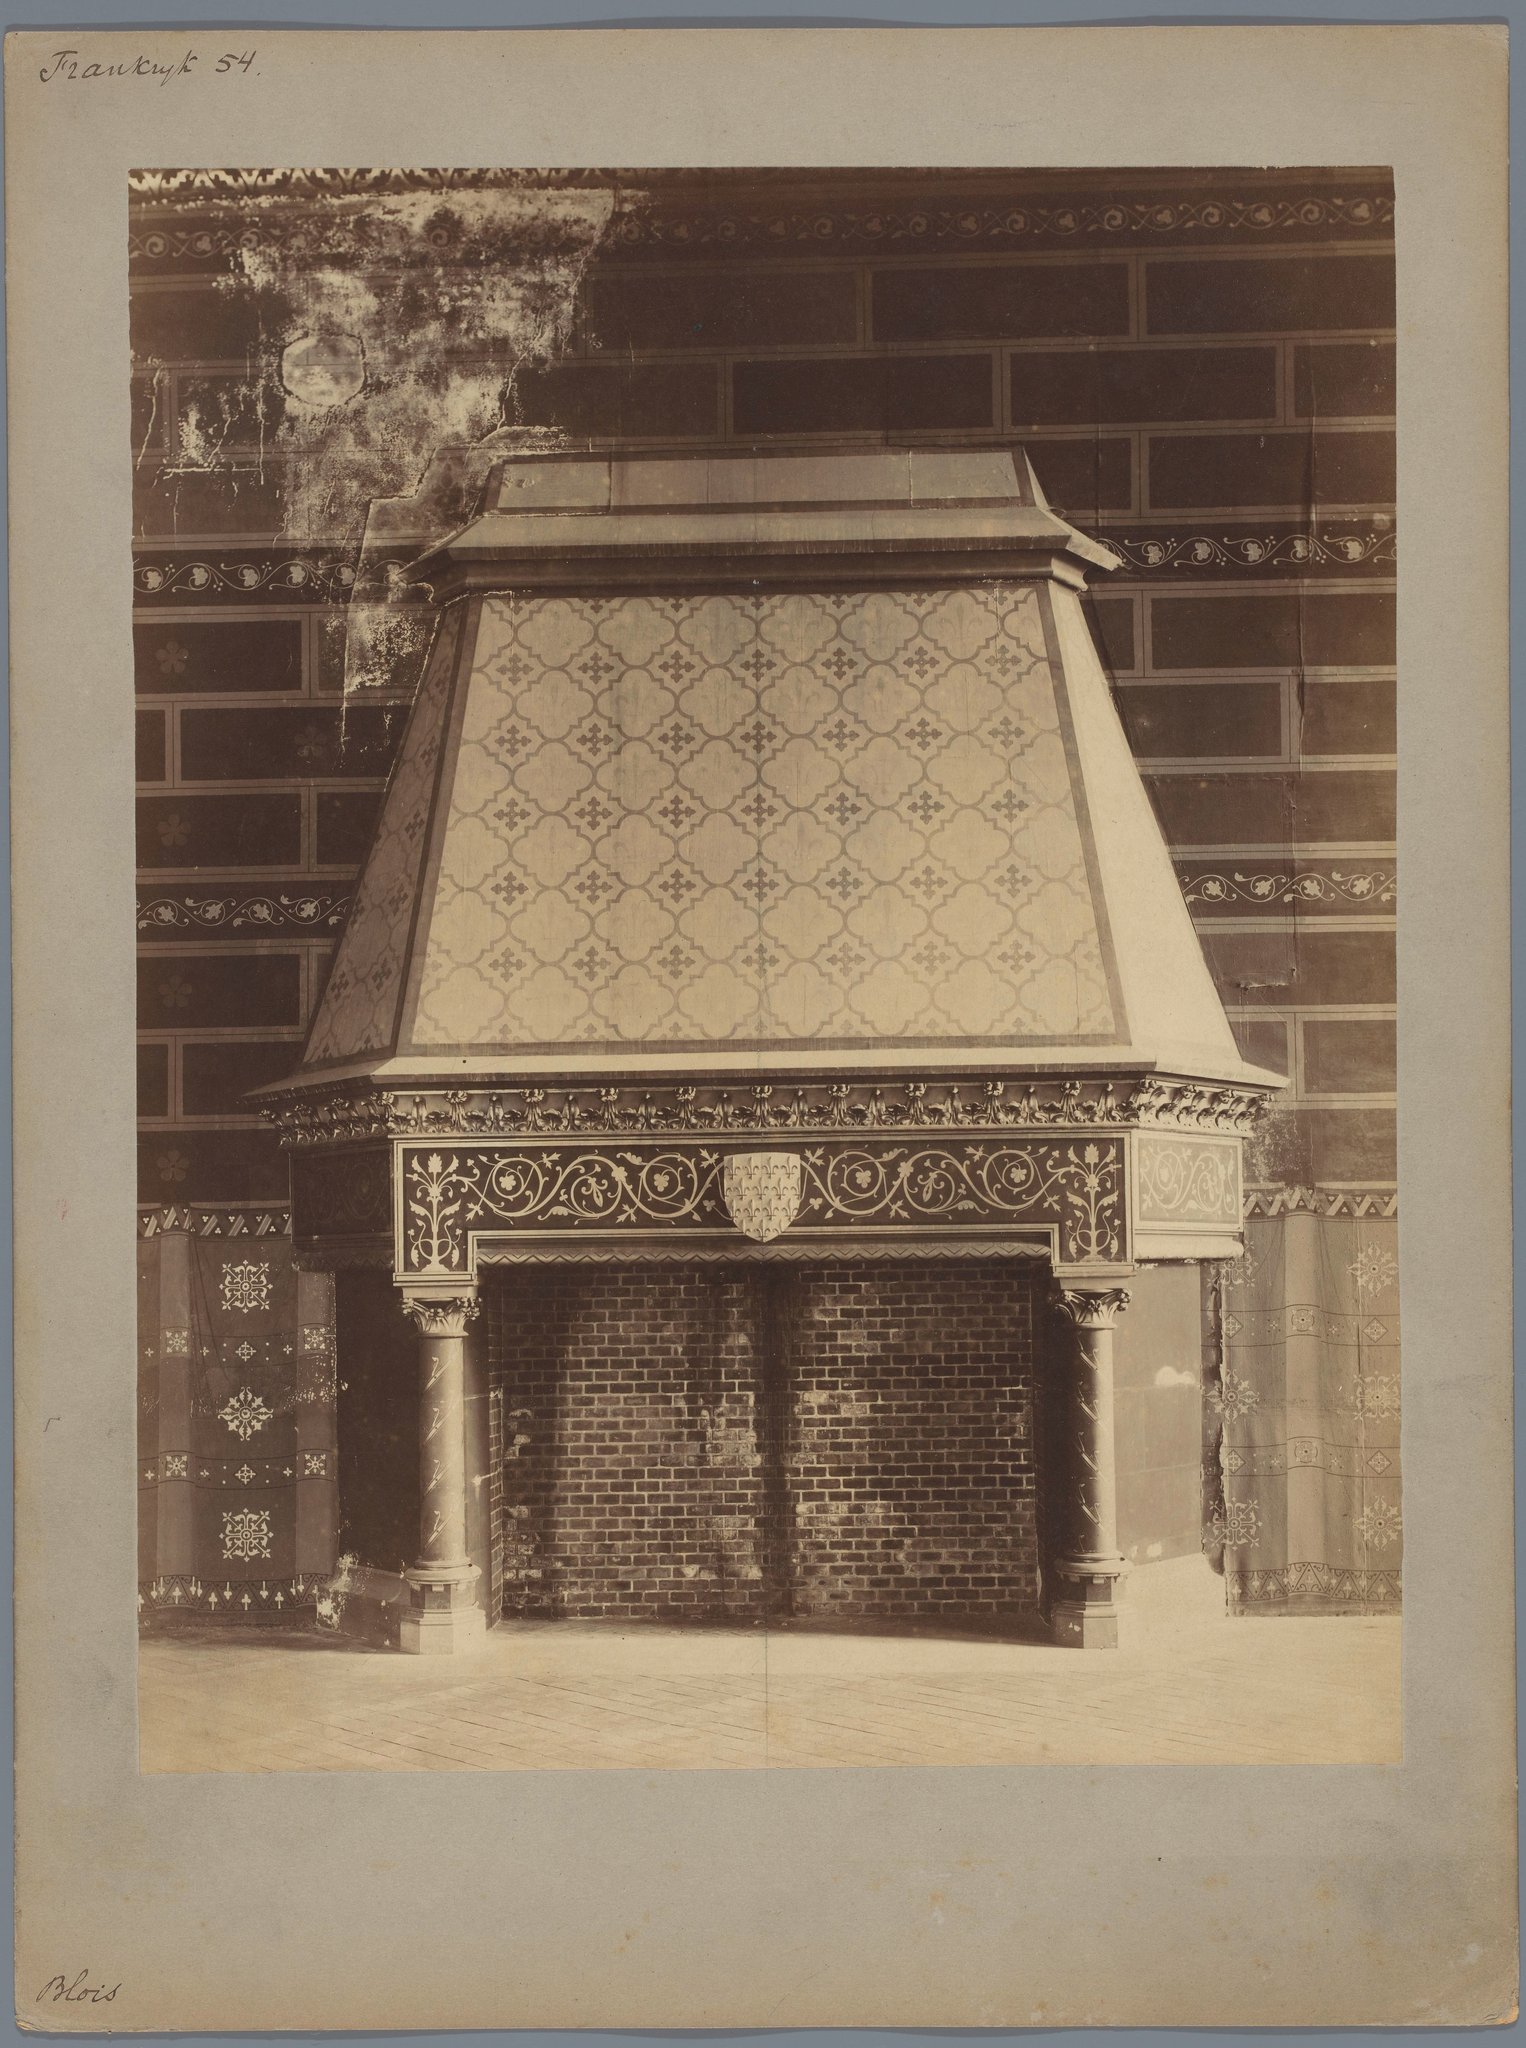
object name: photograph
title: Schoorsteenmantel in het kasteel van Blois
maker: Anonymous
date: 1850-1900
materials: cardboard, photographic support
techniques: albumen print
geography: blois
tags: chimney-piece, mantelpiece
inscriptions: collector's mark: ‘RIJKS NO[RMA]ALSCHOO[L] voor T[EEKENONDERWIJZERS] AMSTERDA[M]’, annotation: ‘Frankrijk 54.’, annotation: ‘Blois’, annotation: ‘Blois’